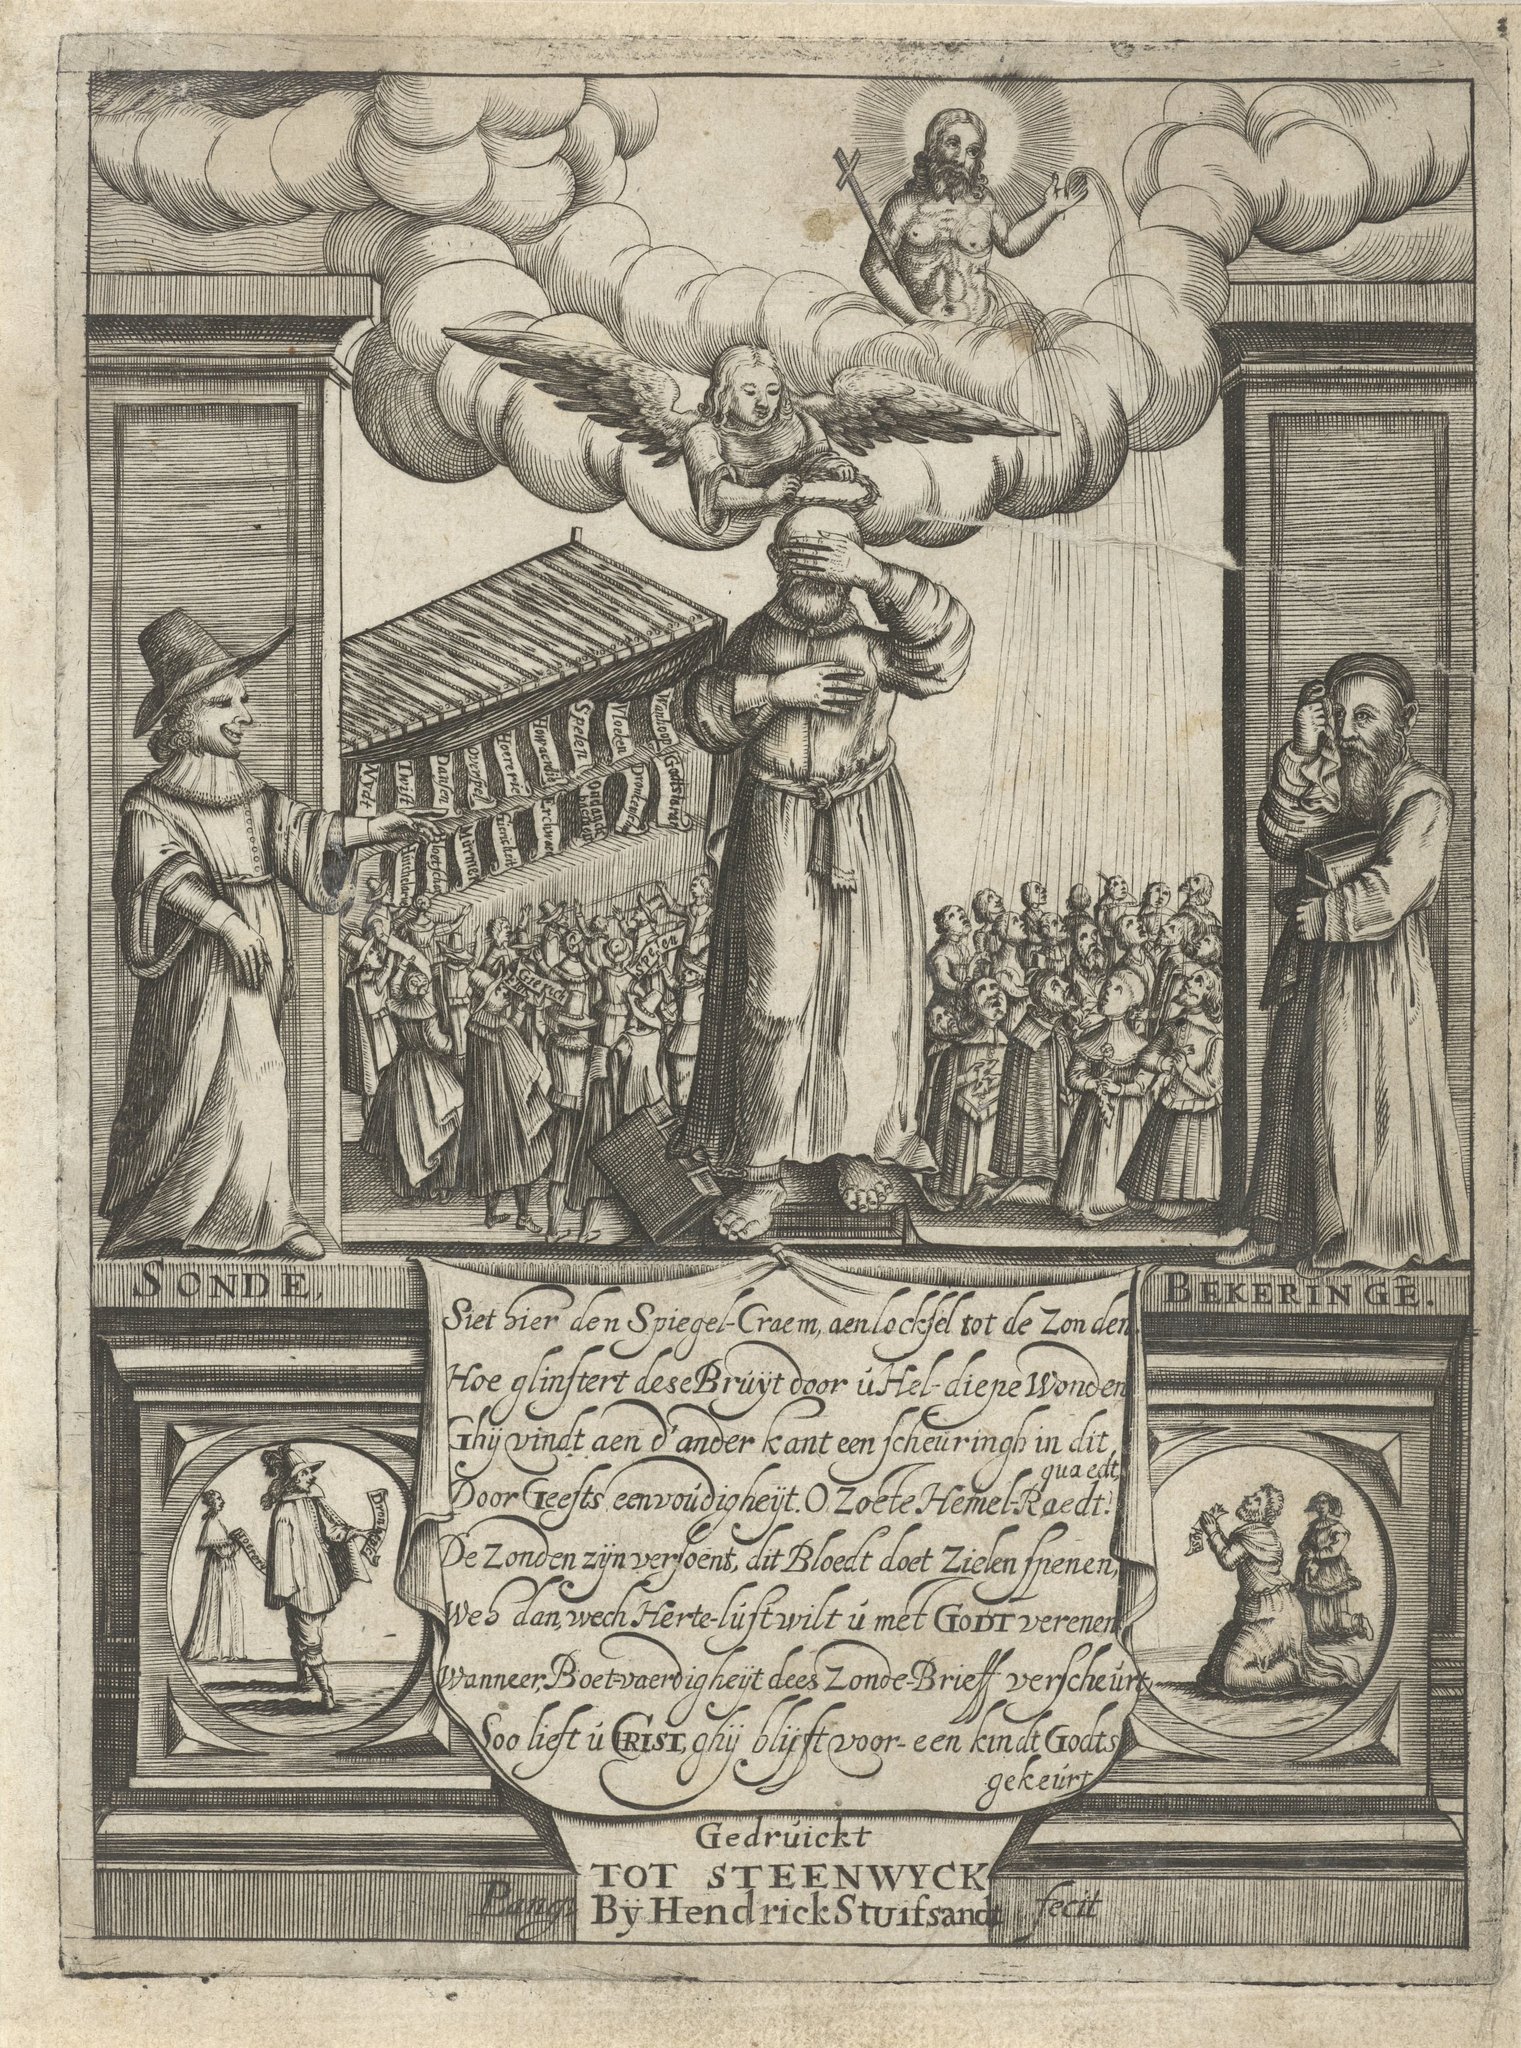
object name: print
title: Titelpagina voor: D. van Baardt, Sondekraem ter bekeerde saligheyt, 1662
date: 1662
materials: paper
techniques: engraving, etching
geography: steenwijk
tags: absolution, forgiveness of sins ~ part of the confession, public penance, general avowal of faults, conversion and belief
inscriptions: collector's mark: Lugt 2228, collector's mark: Lugt 2760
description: Een figuur in een pij heeft zijn ogen afgeschermd om de op papier geschreven zonden die links achter hem in een kraam hangen niet te hoeven zien. Hij wordt door een engel gelauwerd. De figuren rechts achter hem hebben gezondigd maar worden dankzij hun berouw en boetedoening door Christus vergeven. Christus troont met een kruis in zijn handen in de lucht, uit de wonden in zijn zij en hand stroomt bloed neer op de figuren die hij zijn vergiffenis heeft geschonken. Links en rechts van de centrale voorstelling staan personificaties van de zonde en bekering. Onderaan hangt een doek met een achtregelig Nederlands vers. Links van het vers staat een beeltenis van twee zondaars, rechts een beeltenis van twee boetelingen.